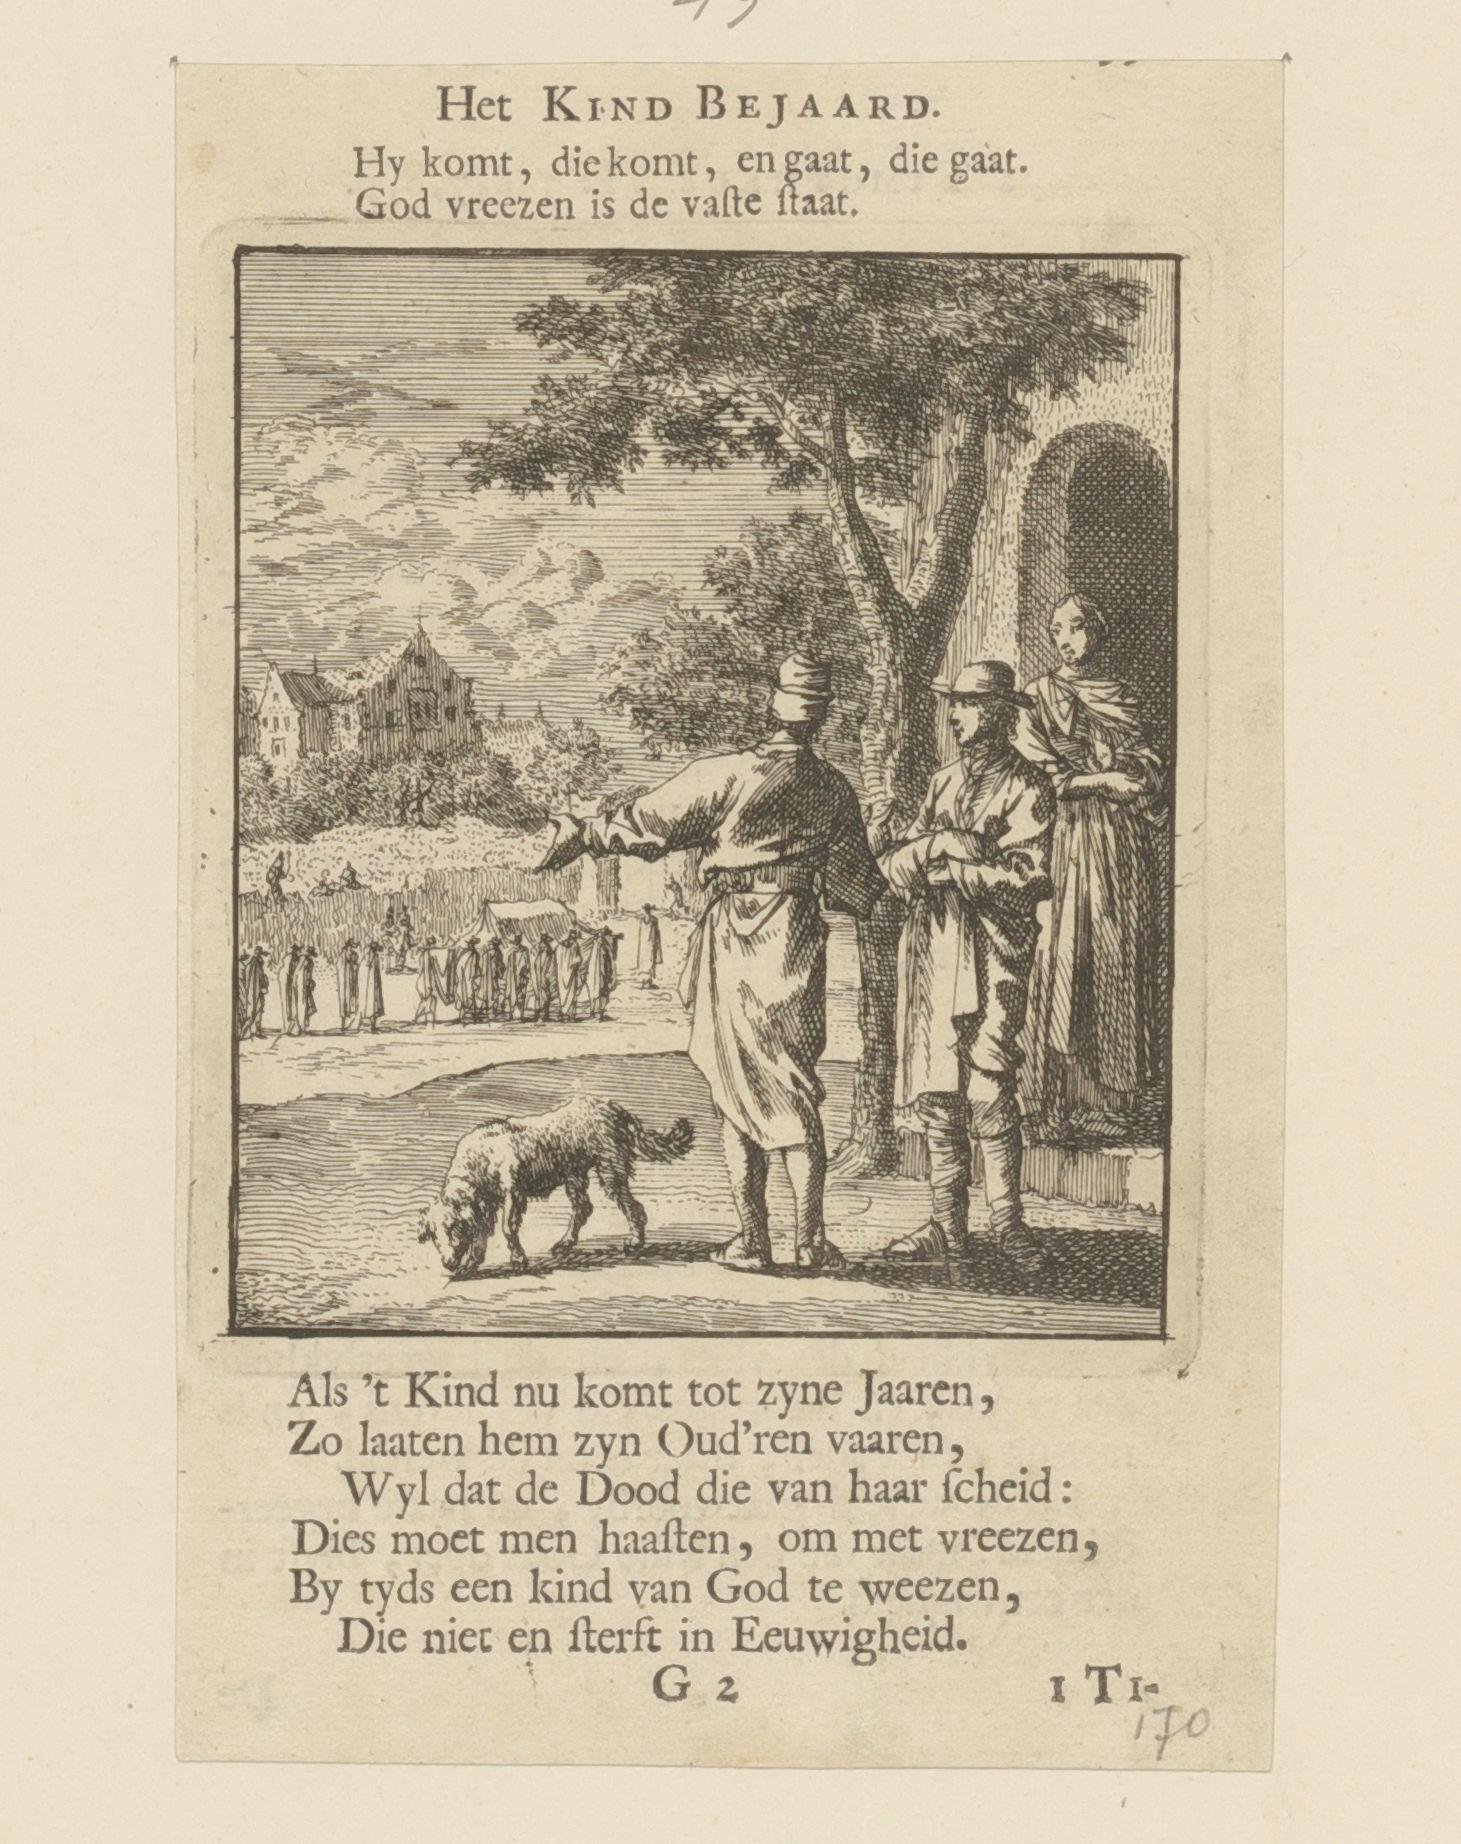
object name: print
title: Het Kind Bejaard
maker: jan luyken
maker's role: draughtsman, print maker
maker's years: 1649-1712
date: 1712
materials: paper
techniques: etching, letterpress printing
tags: funerary ceremonial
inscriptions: stamp, stamp, collector's mark: Lugt 1641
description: Onderaan een zesregelig vers. Onderwerpsrubrieken binnen de Atlas Zeden en Gewoonten: Zeden en Gewoonten in Engeren Zin, Des menschen beging, midden en einde, Kinderleven – Kinderspel en Kinderprenten.